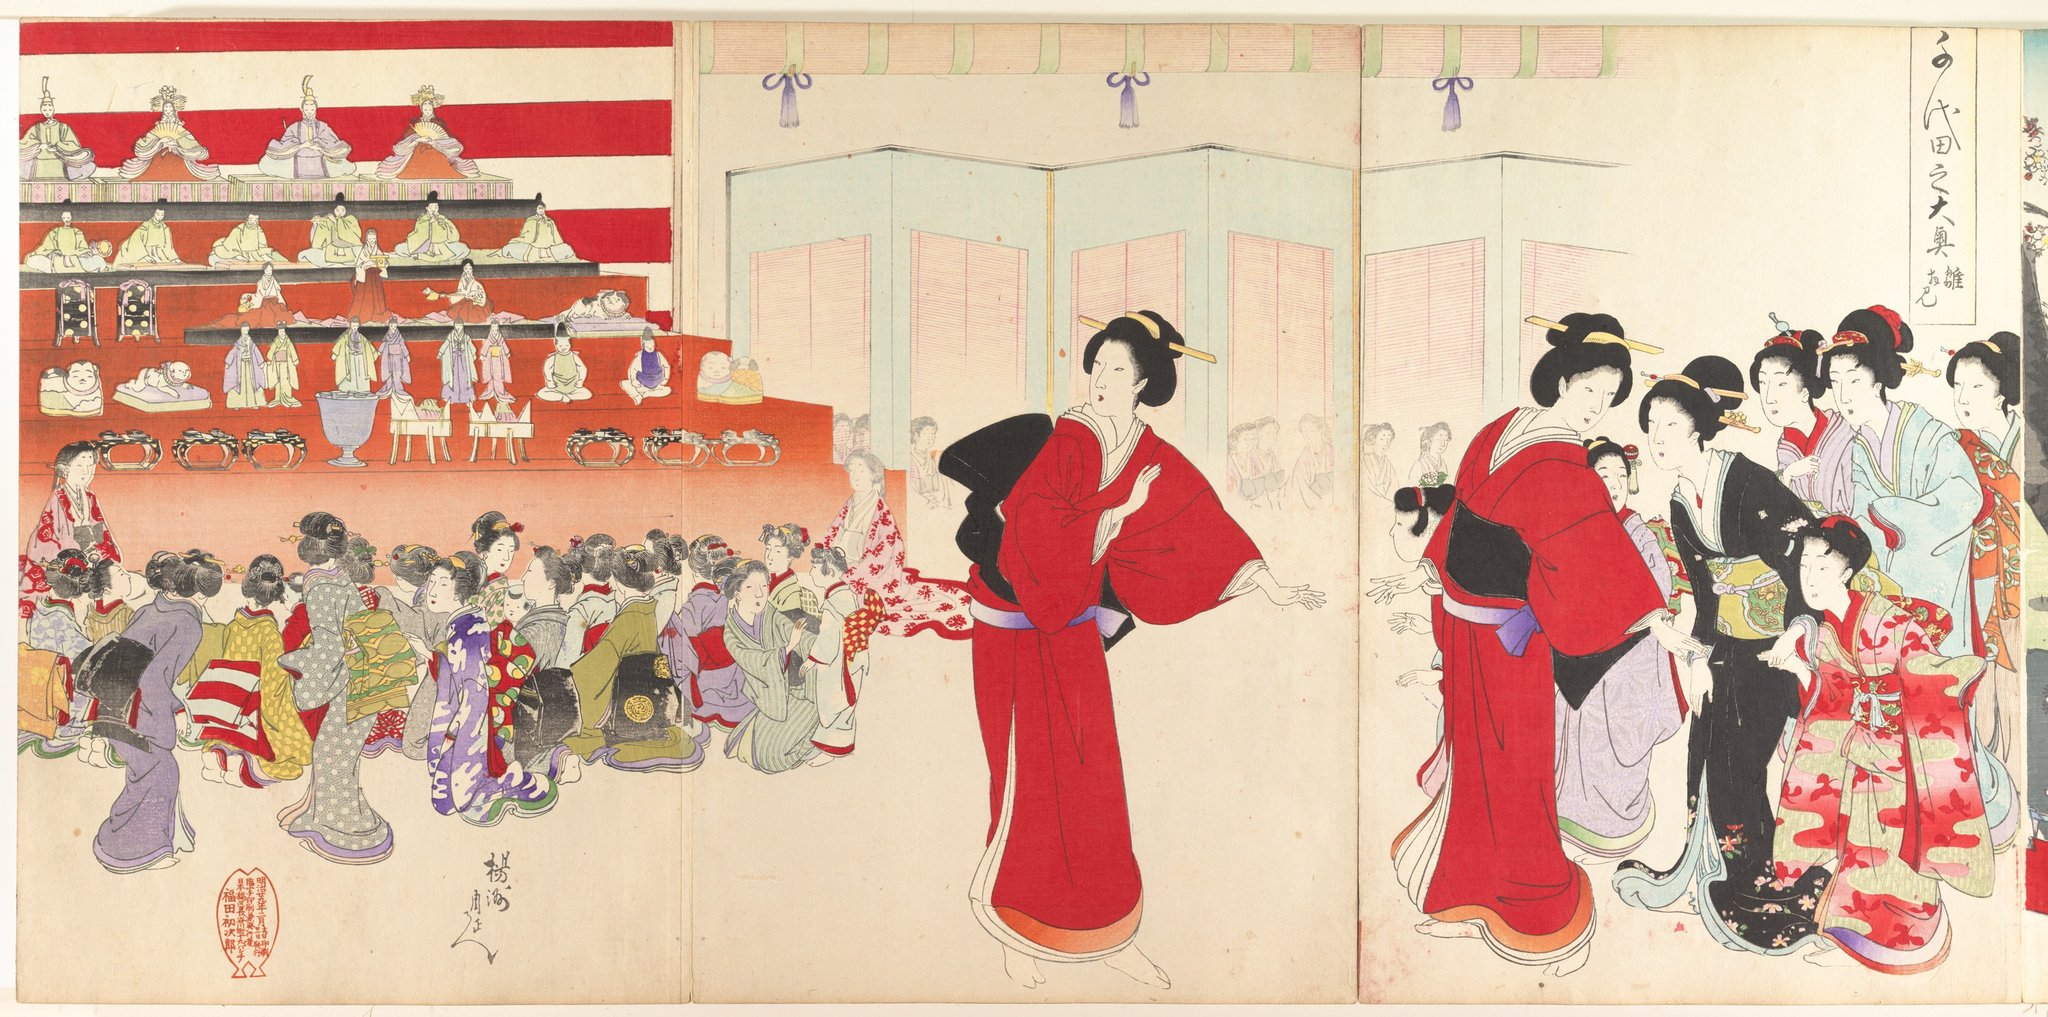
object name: print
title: Chiyoda Castle (Album of Women)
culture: japanese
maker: yōshū (hashimoto) chikanobu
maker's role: artist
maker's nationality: japanese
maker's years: 1838-1912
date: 1895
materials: ink, paper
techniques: woodblock print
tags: women,crowd